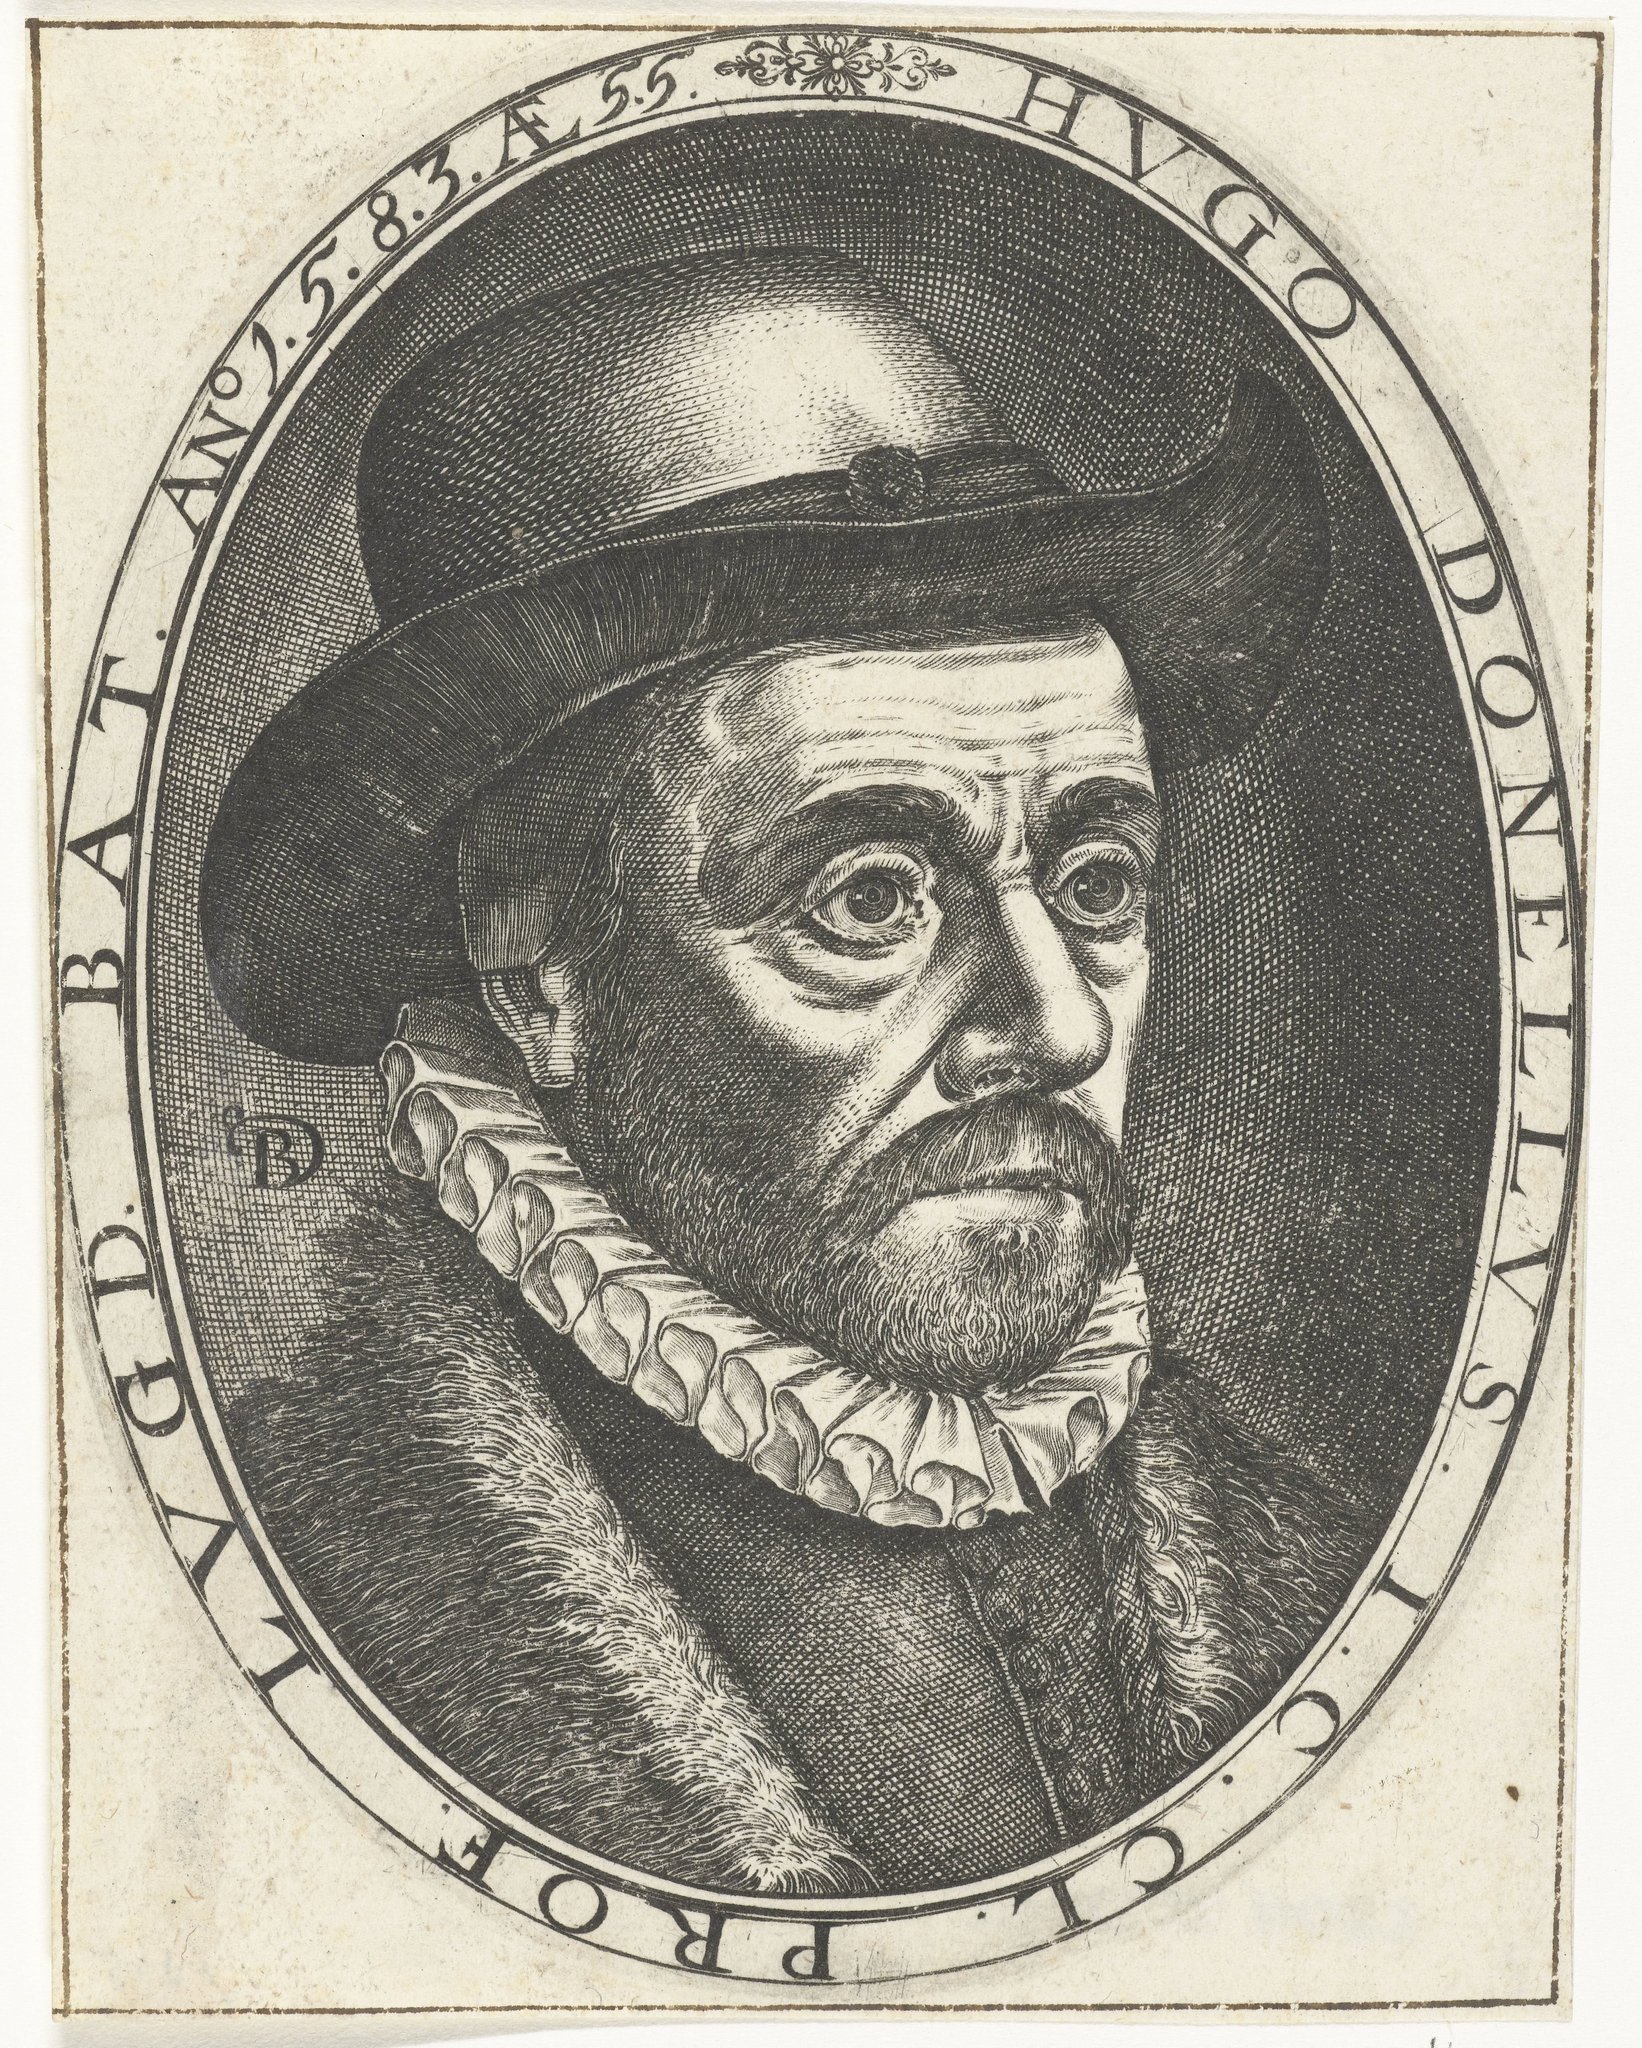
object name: print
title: Portret van Hugo Donellus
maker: bartholomeus willemsz. dolendo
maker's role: print maker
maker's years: 1560-1626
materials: paper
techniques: engraving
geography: leiden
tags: châlon-sur-saône, altdorf, rechtsgeleerde, professor, hugo donellus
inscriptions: collector's mark: Lugt 692, collector's mark: Lugt 2228